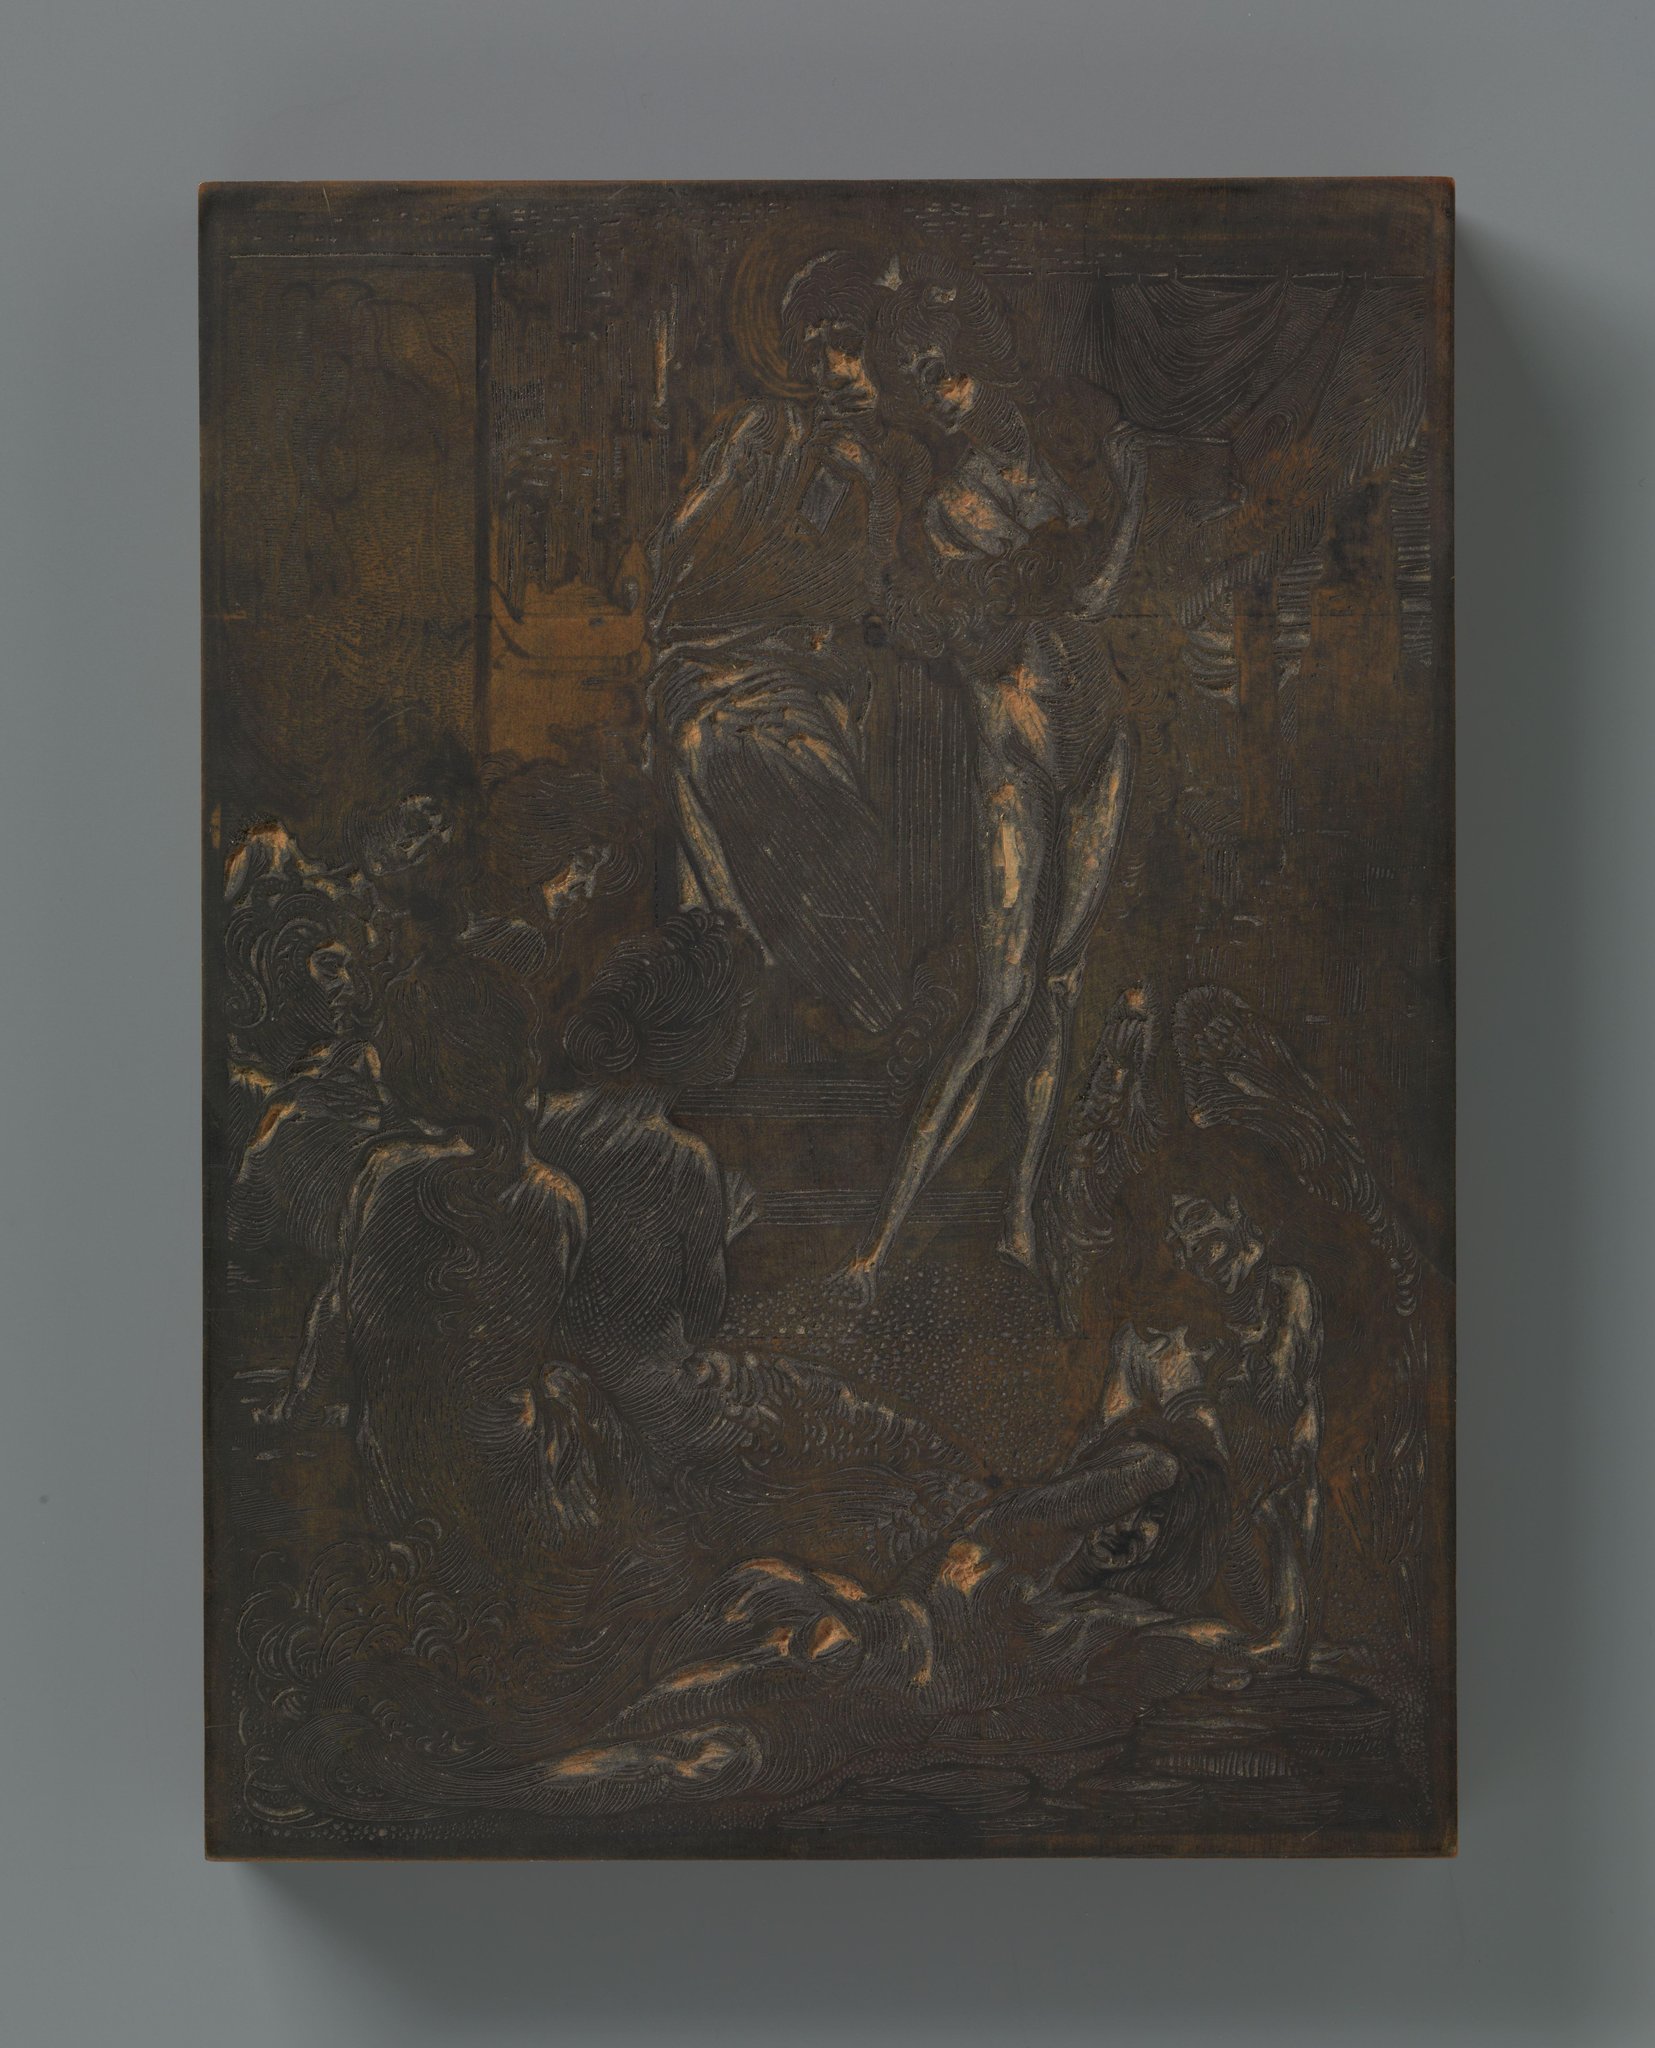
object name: wood block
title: Compositie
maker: johannes josephus aarts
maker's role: draughtsman, print maker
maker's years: 1871-1934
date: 1897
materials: wood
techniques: woodcut